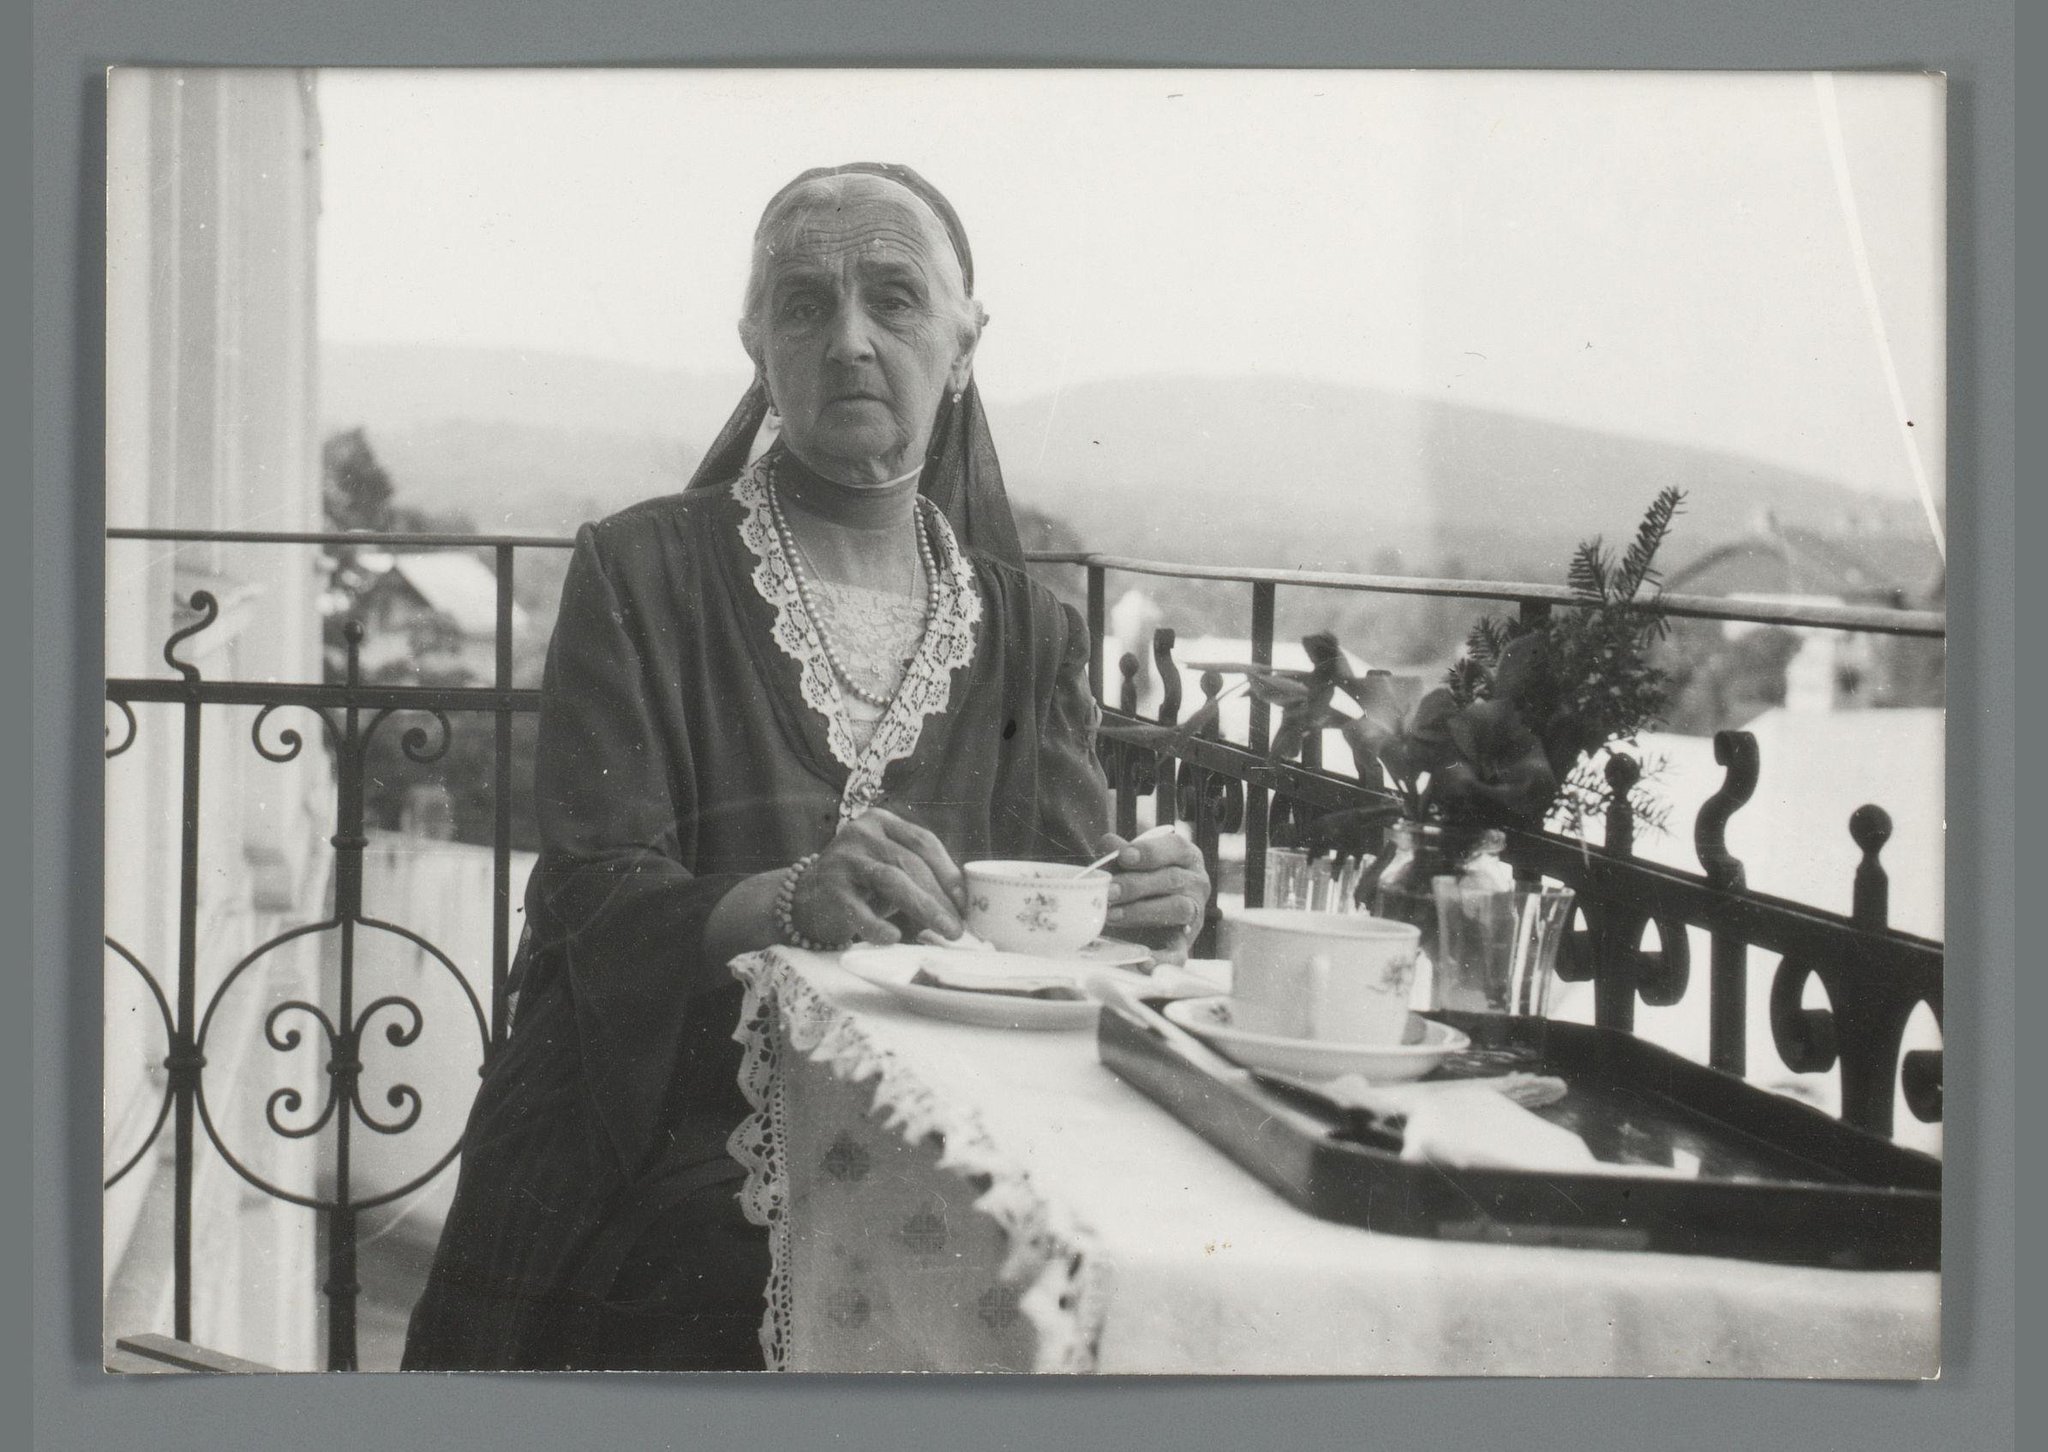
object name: photograph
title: Portret van een onbekende vrouw op een balkon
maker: Anonymous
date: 1920-1950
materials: paper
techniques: gelatin silver print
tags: historical persons not known by name - bb - woman, old woman